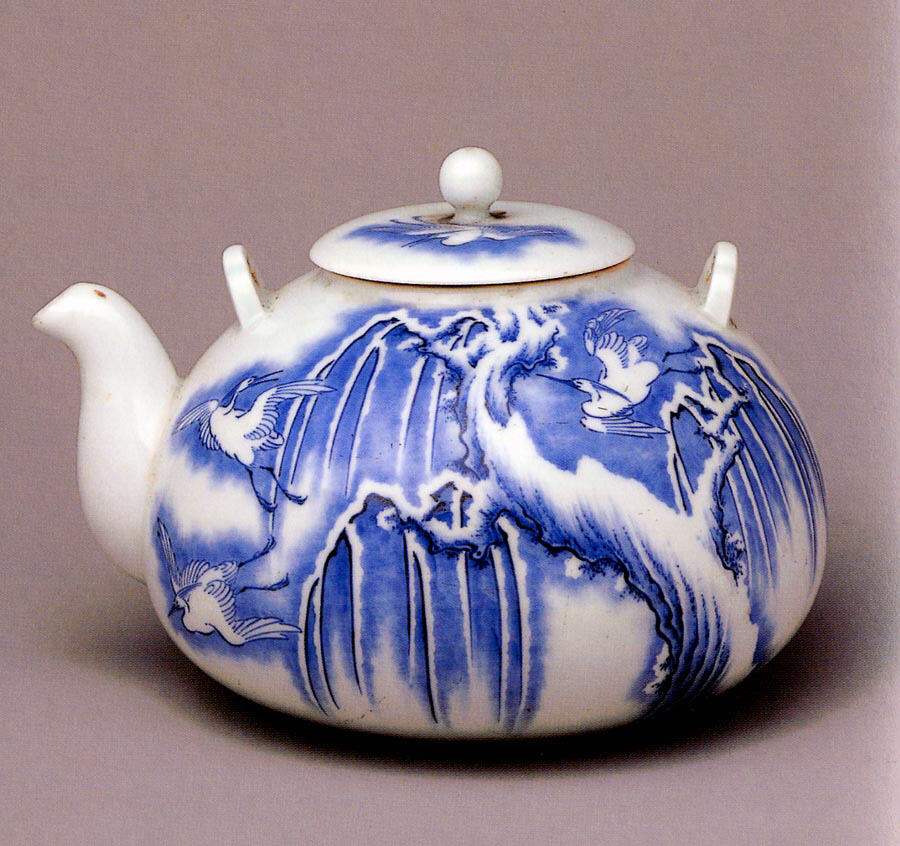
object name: teapot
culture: japanese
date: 1820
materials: glaze, porcelain